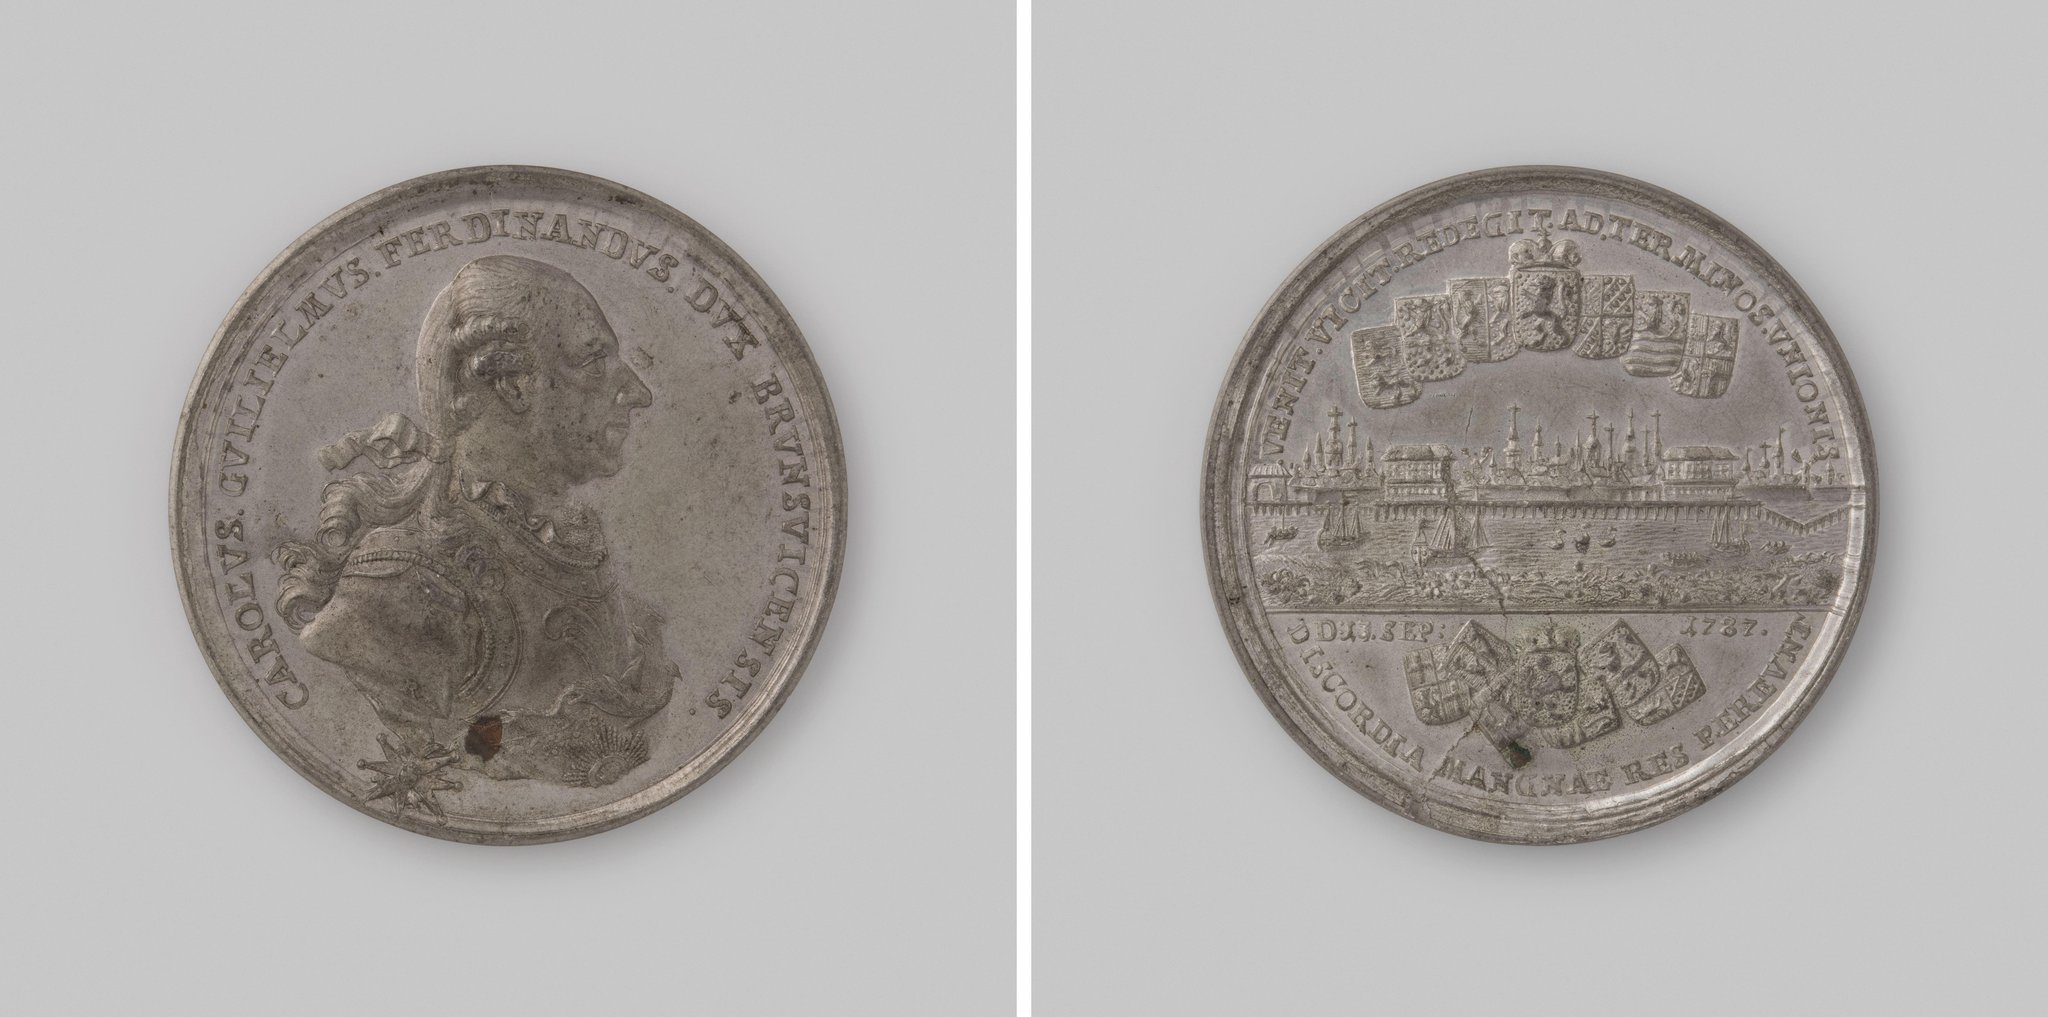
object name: history medal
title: Karel Willem Ferdinand hertog van Brunswijk en de capitulatie van Amsterdam 1787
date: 1787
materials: copper, tin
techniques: striking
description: Tinnen penning met kleine koperen plug, op de voorzijde het borstbeeld van de Hertog naar rechts met omschrift, op de keerzijde het aanzicht van Amsterdam met de blokhuizen aan de Amstelzijde, met onder en boven de wapens der zeven provinciën, onderaan wanordelijk, bovenaan geordend, met omschrift en afsnedetekst.